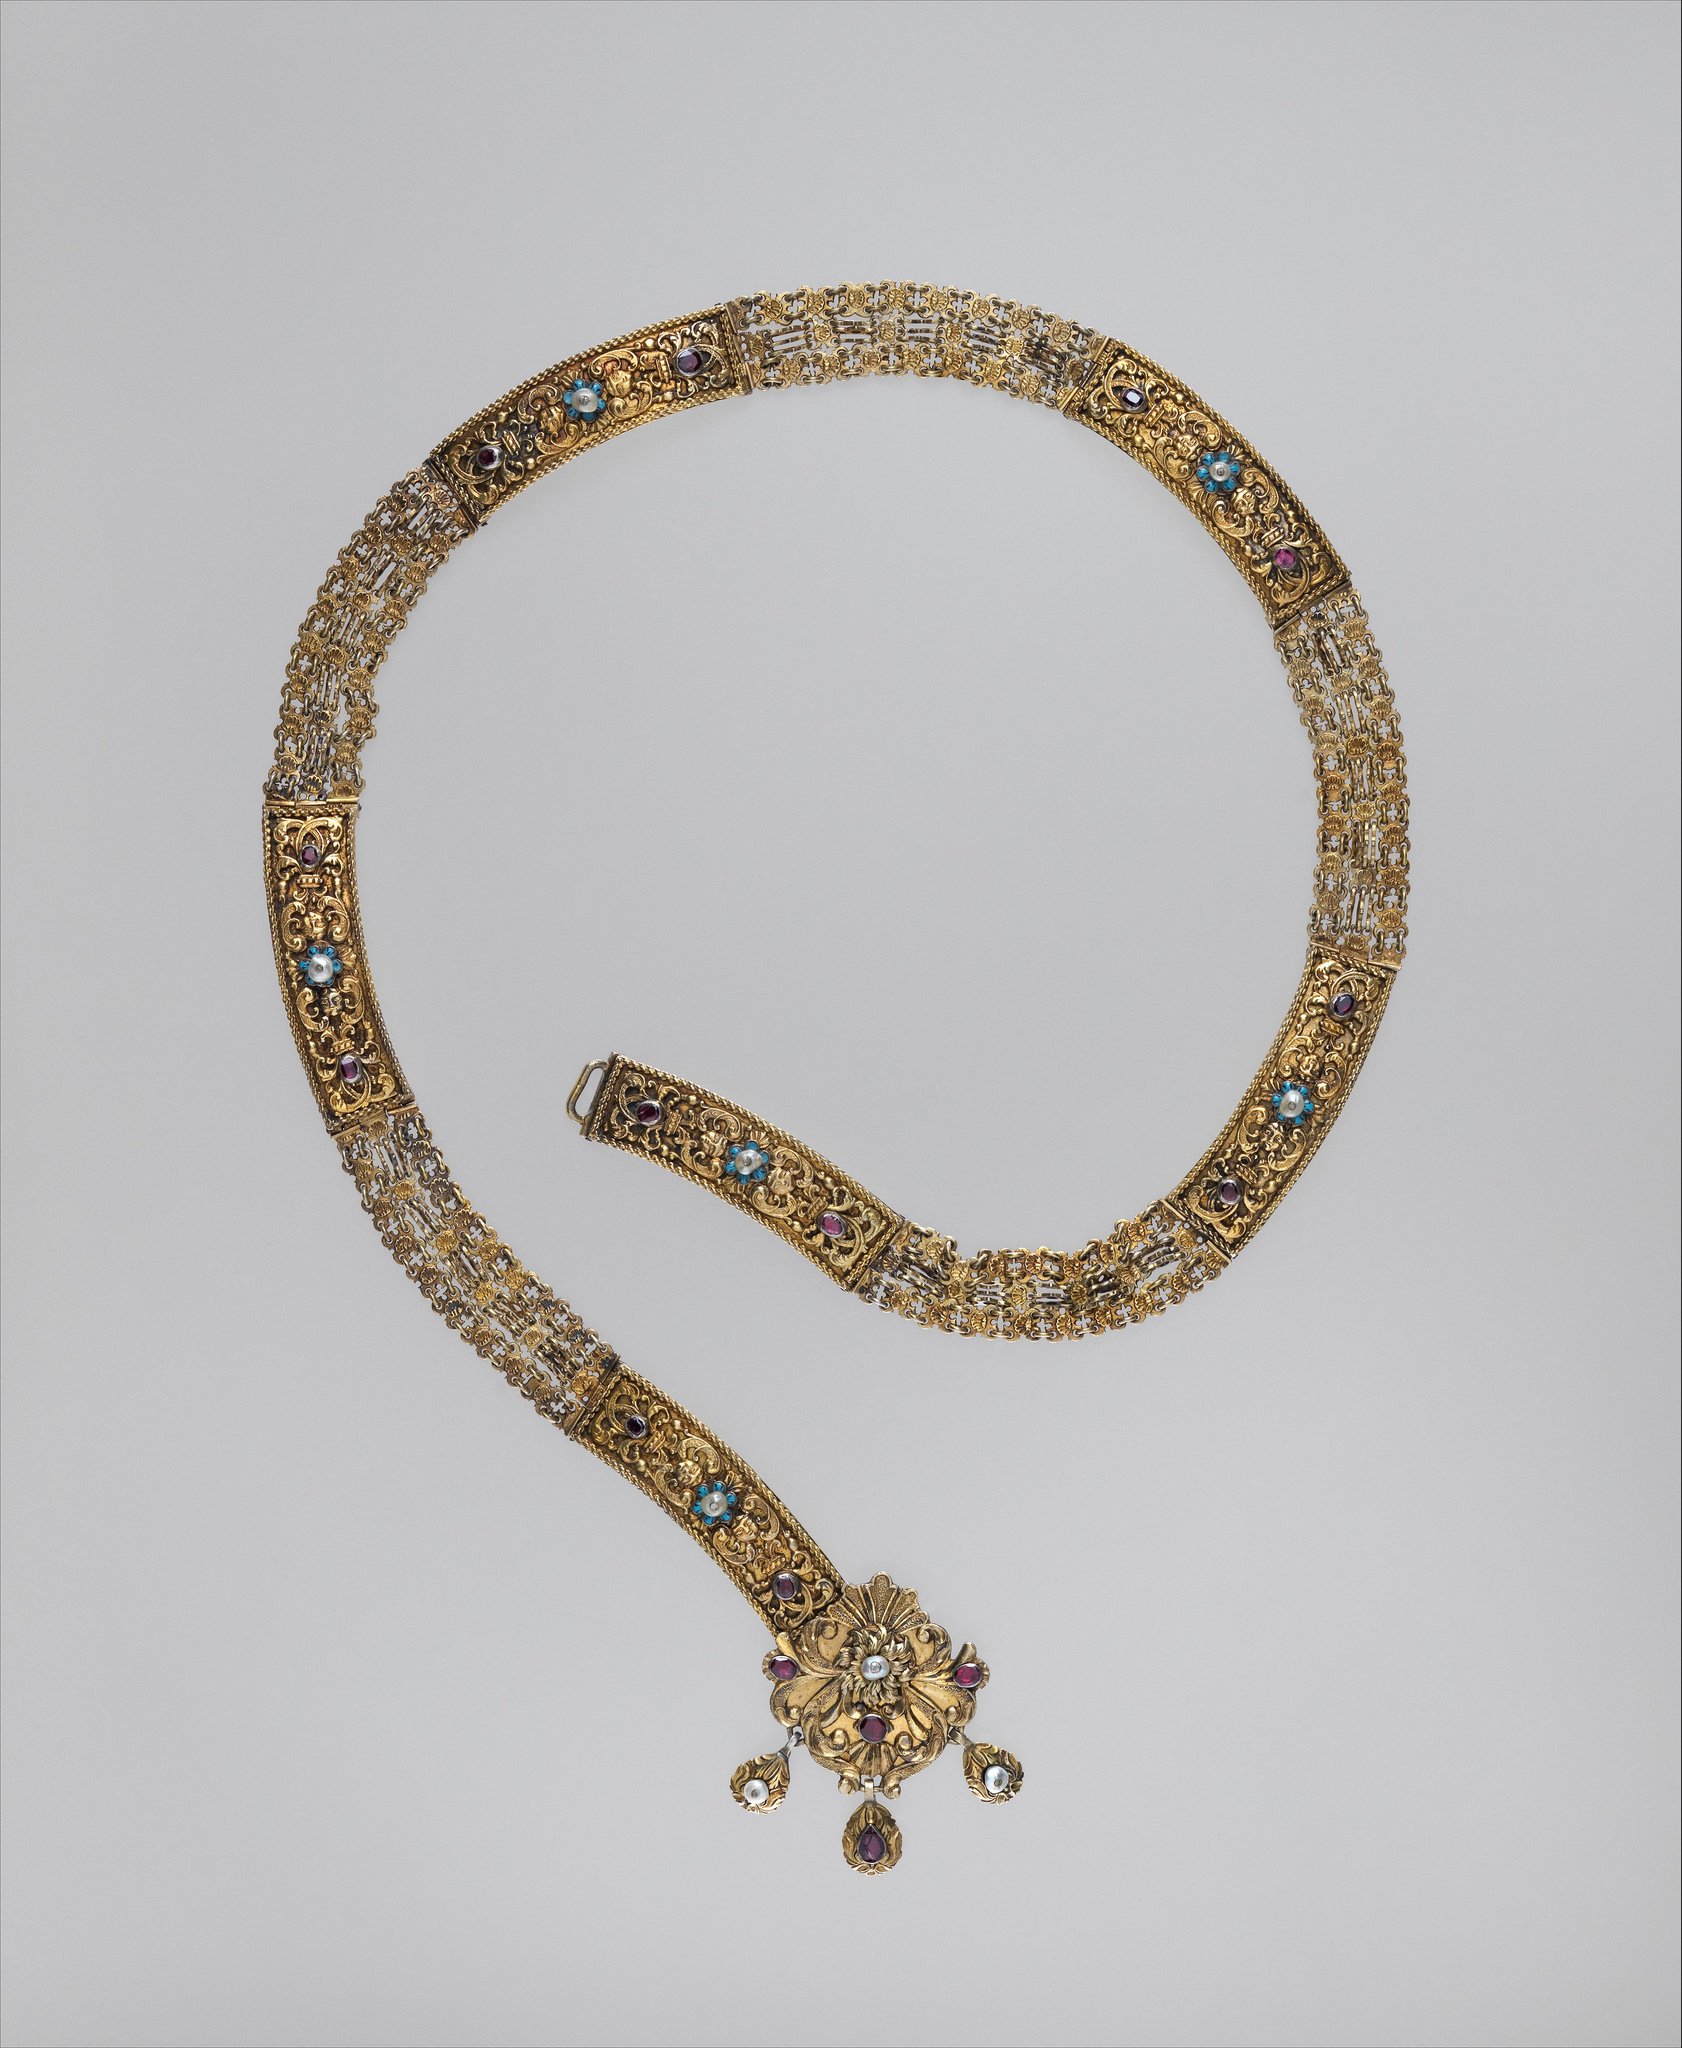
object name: belt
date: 1734-1766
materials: garnet, gilt silver, pearl